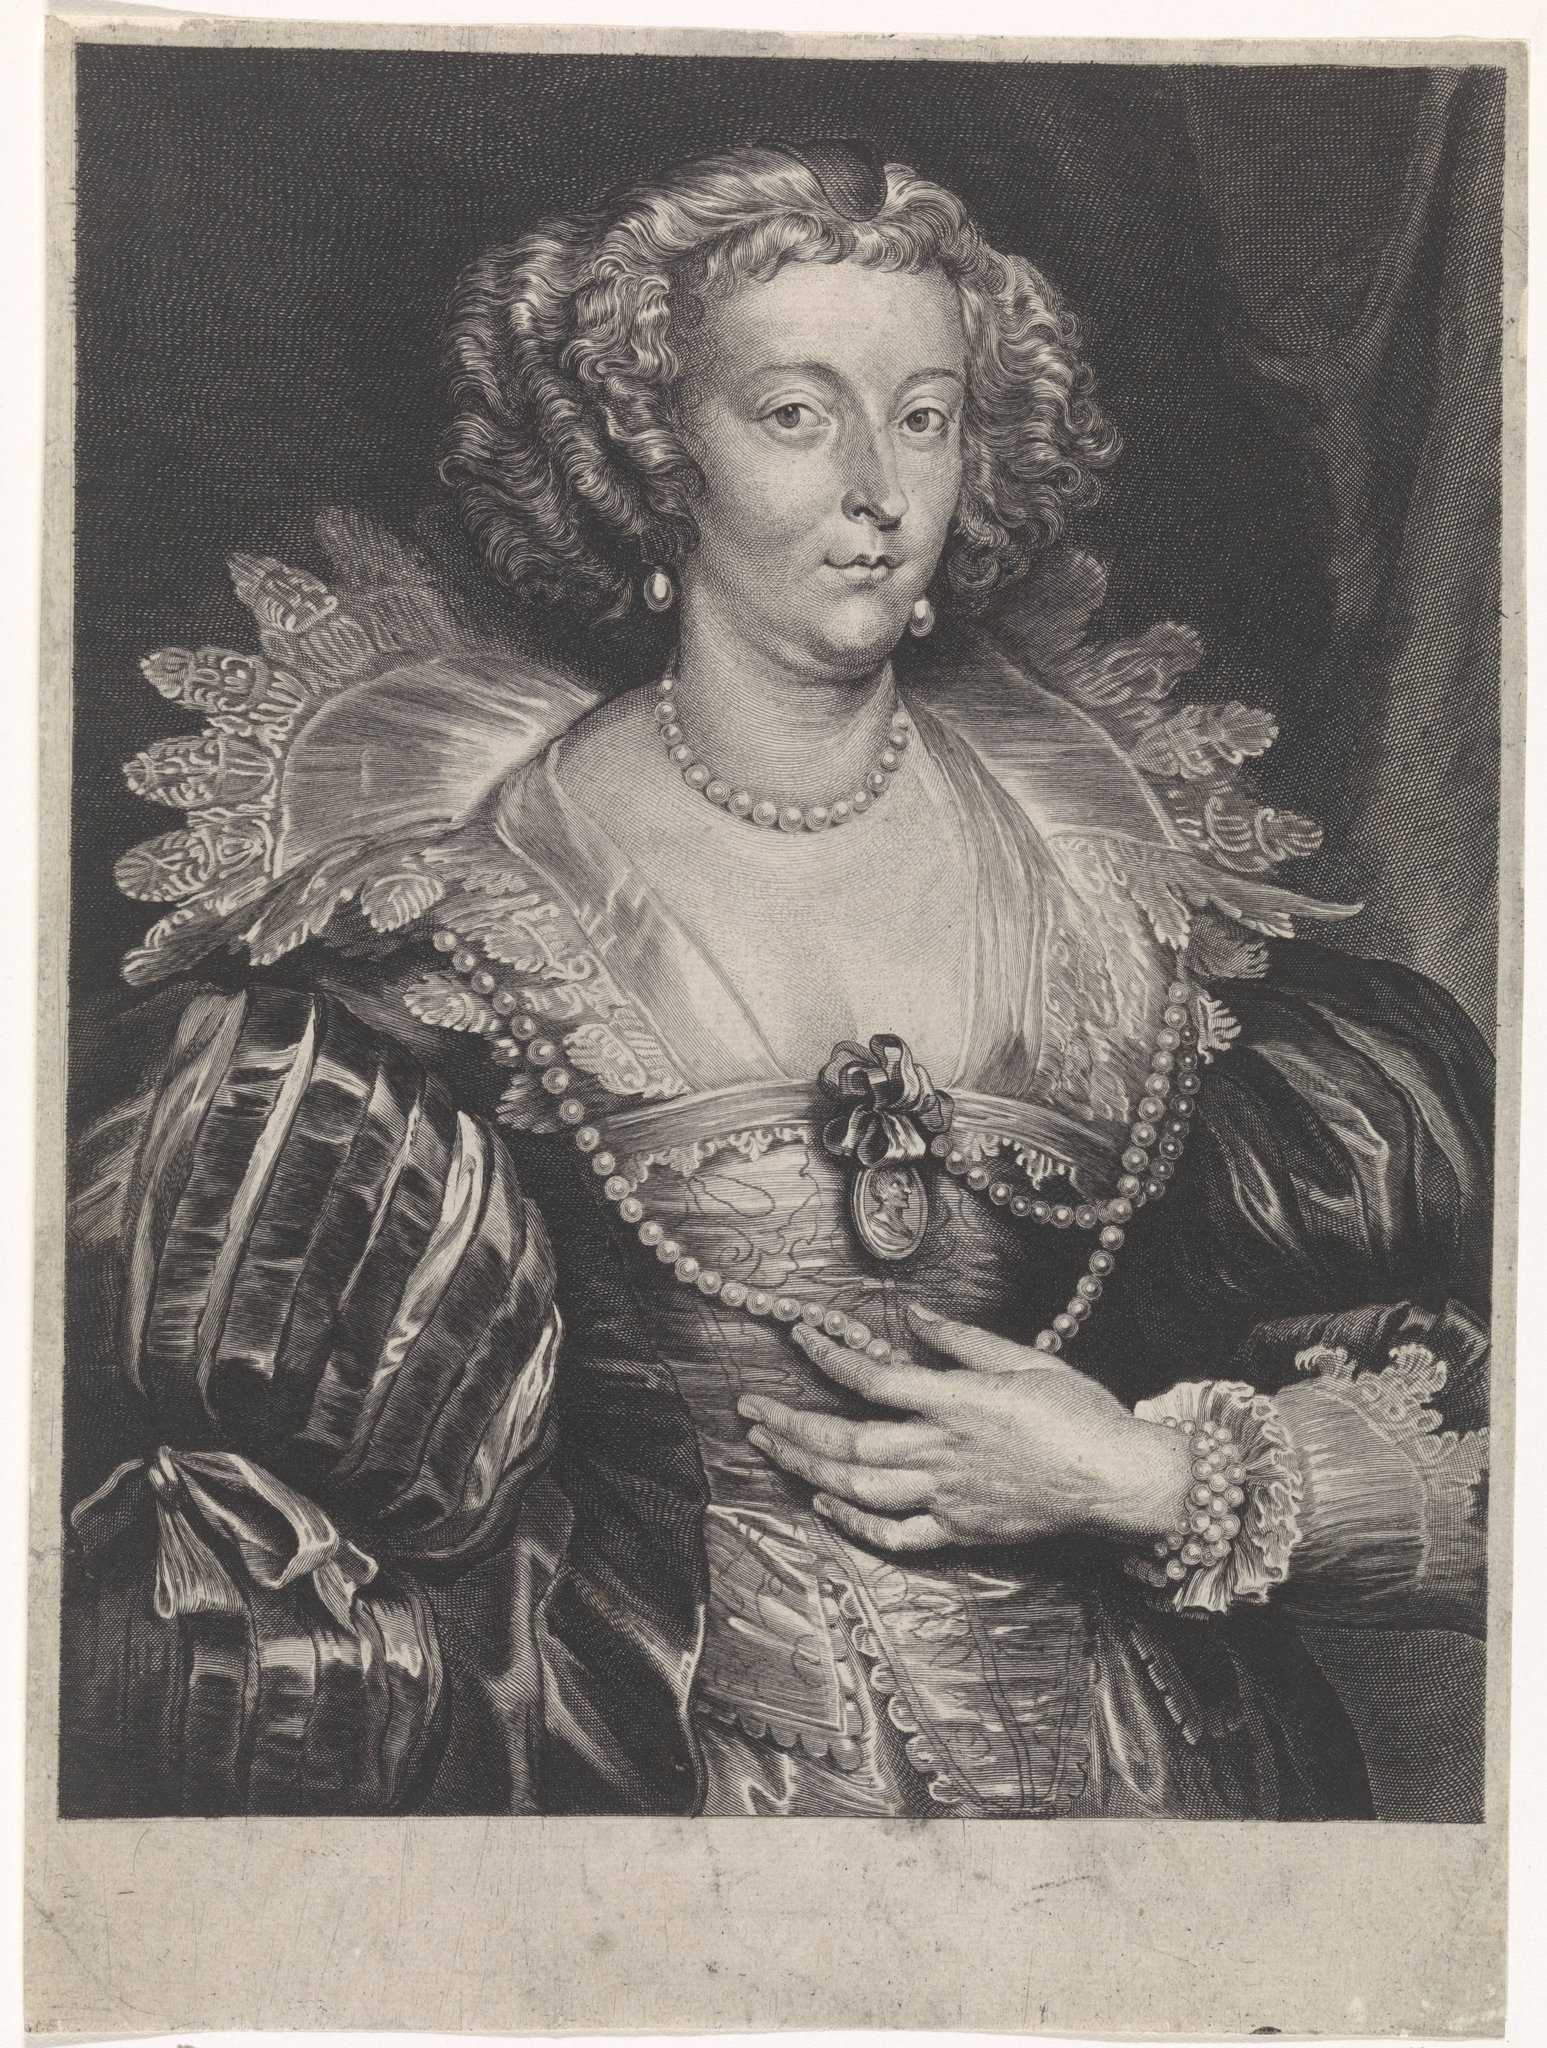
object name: print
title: Portret van Geneviève d'Urfé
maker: pieter de jode (ii)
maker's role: draughtsman, print maker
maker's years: 1606-1674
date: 1628-1670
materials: paper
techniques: engraving, etching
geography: antwerp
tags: hertogin, geneviève d'urfé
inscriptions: collector's mark: Lugt 240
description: Portret van Geneviève d'Urfé, ten halven lijve. Ze houdt haar linkerhand tegen haar buik. Met een lege marge.